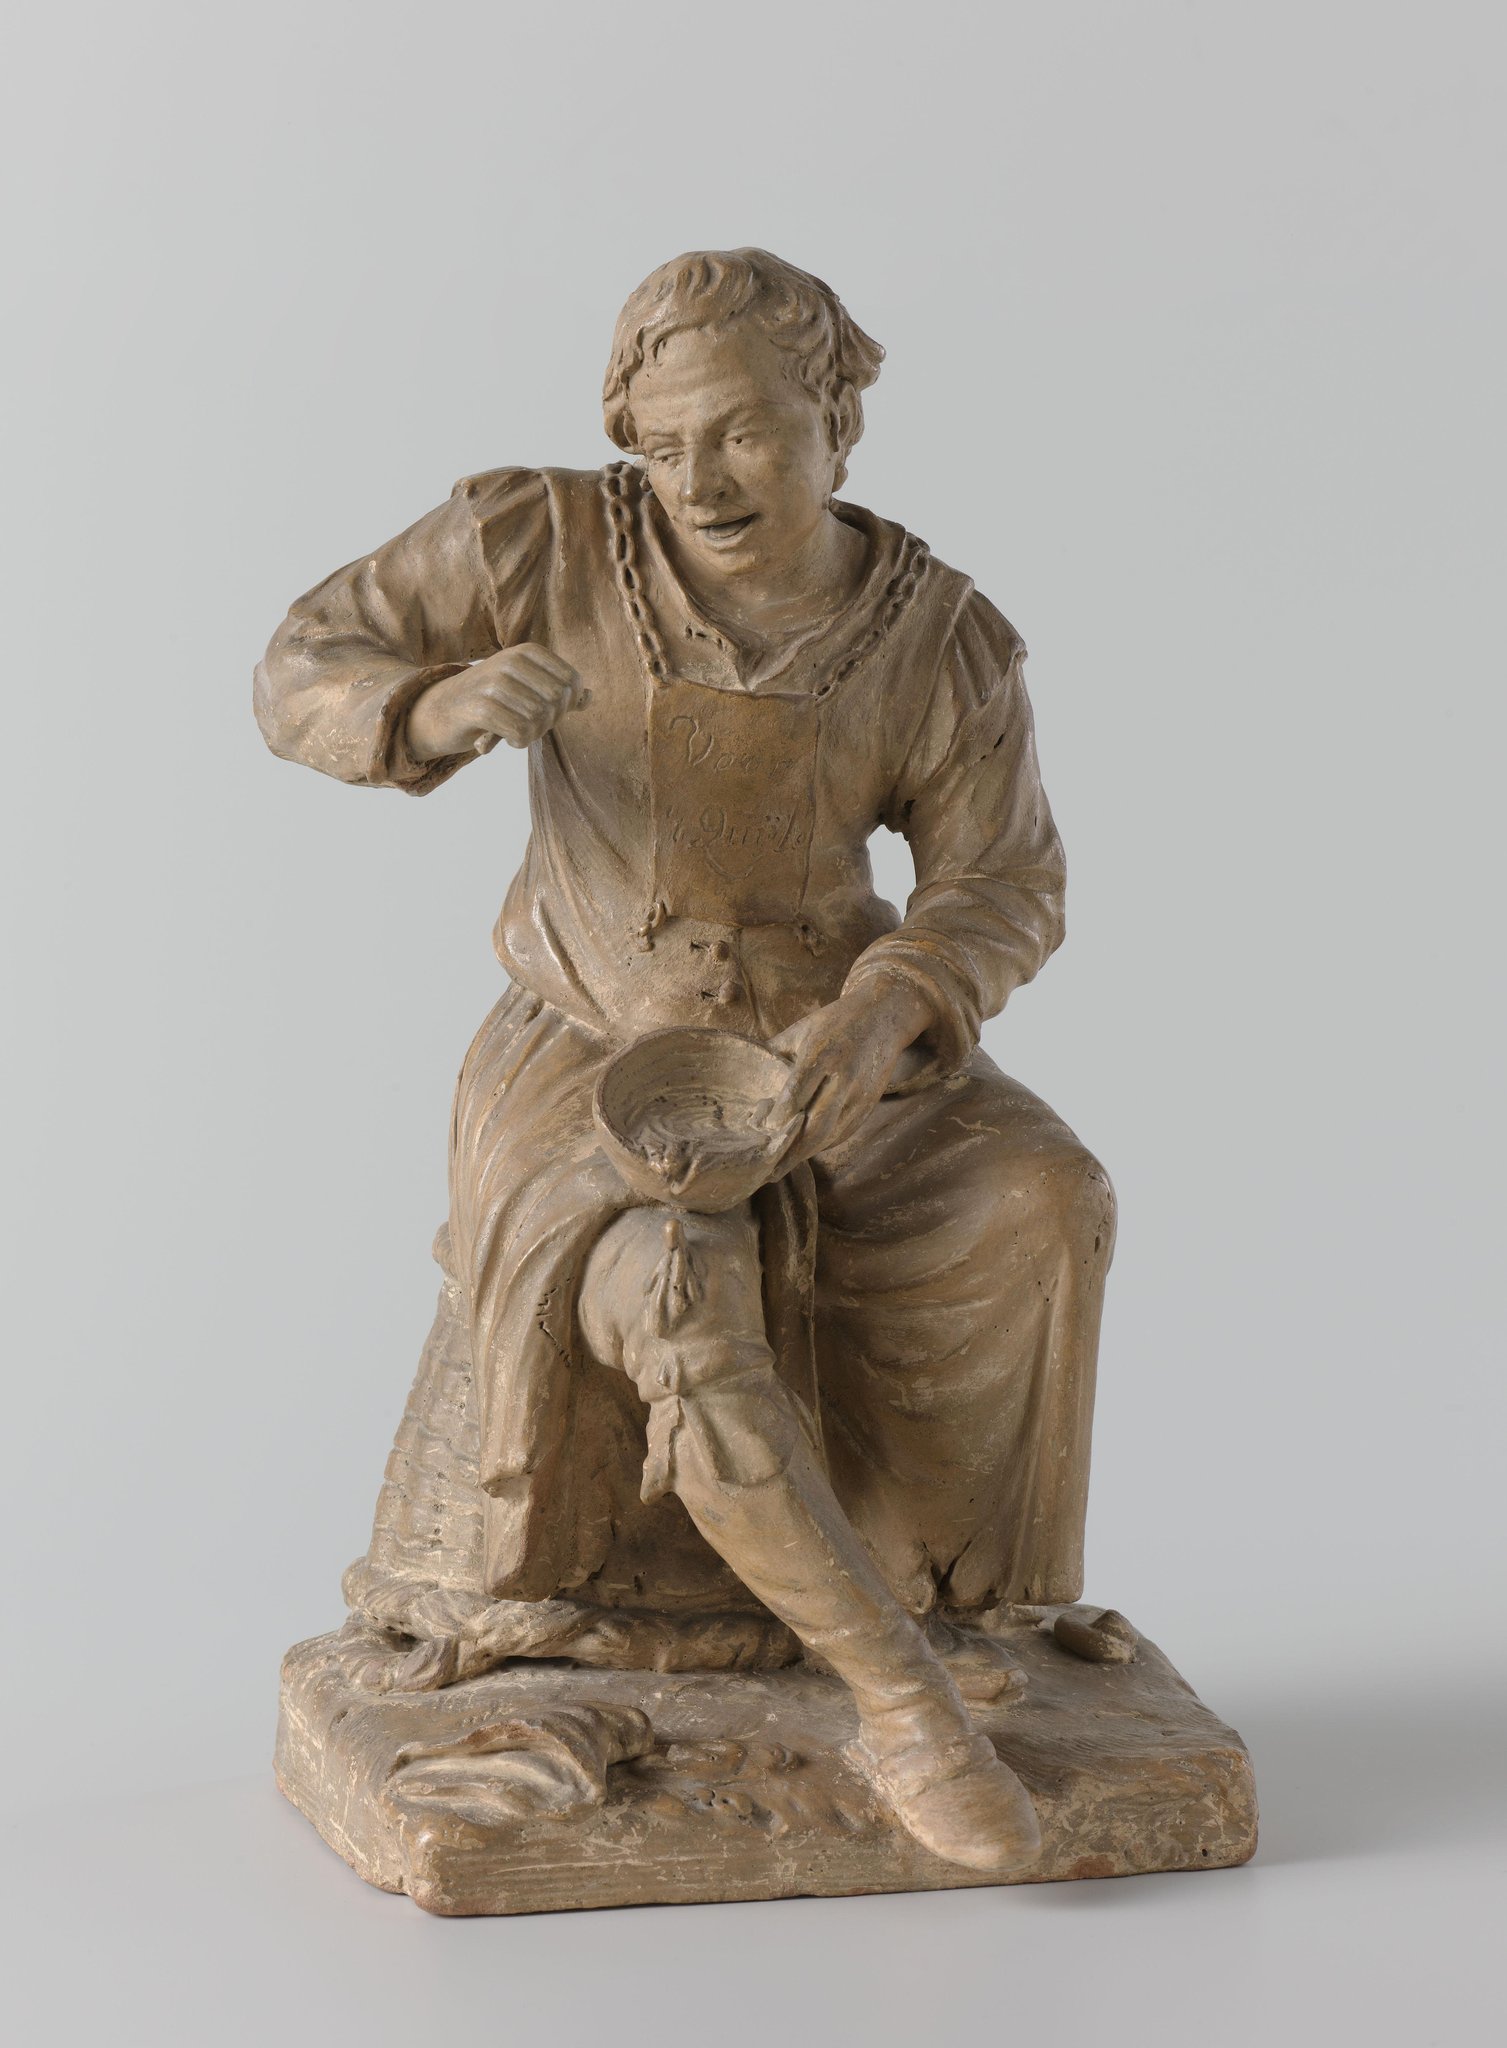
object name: sculpture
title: Young Man Eating Porridge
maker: jan smeltzing (i)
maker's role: modelleur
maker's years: 1656-1693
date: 1690-1710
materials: terracotta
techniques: modeling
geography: leiden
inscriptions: monogram, front right along the raised edge of the base, incised in the wet clay: ‘JS’, inscription, on the figure’s breastplate, incised in the wet clay: ‘Voor ‘t Quijle’